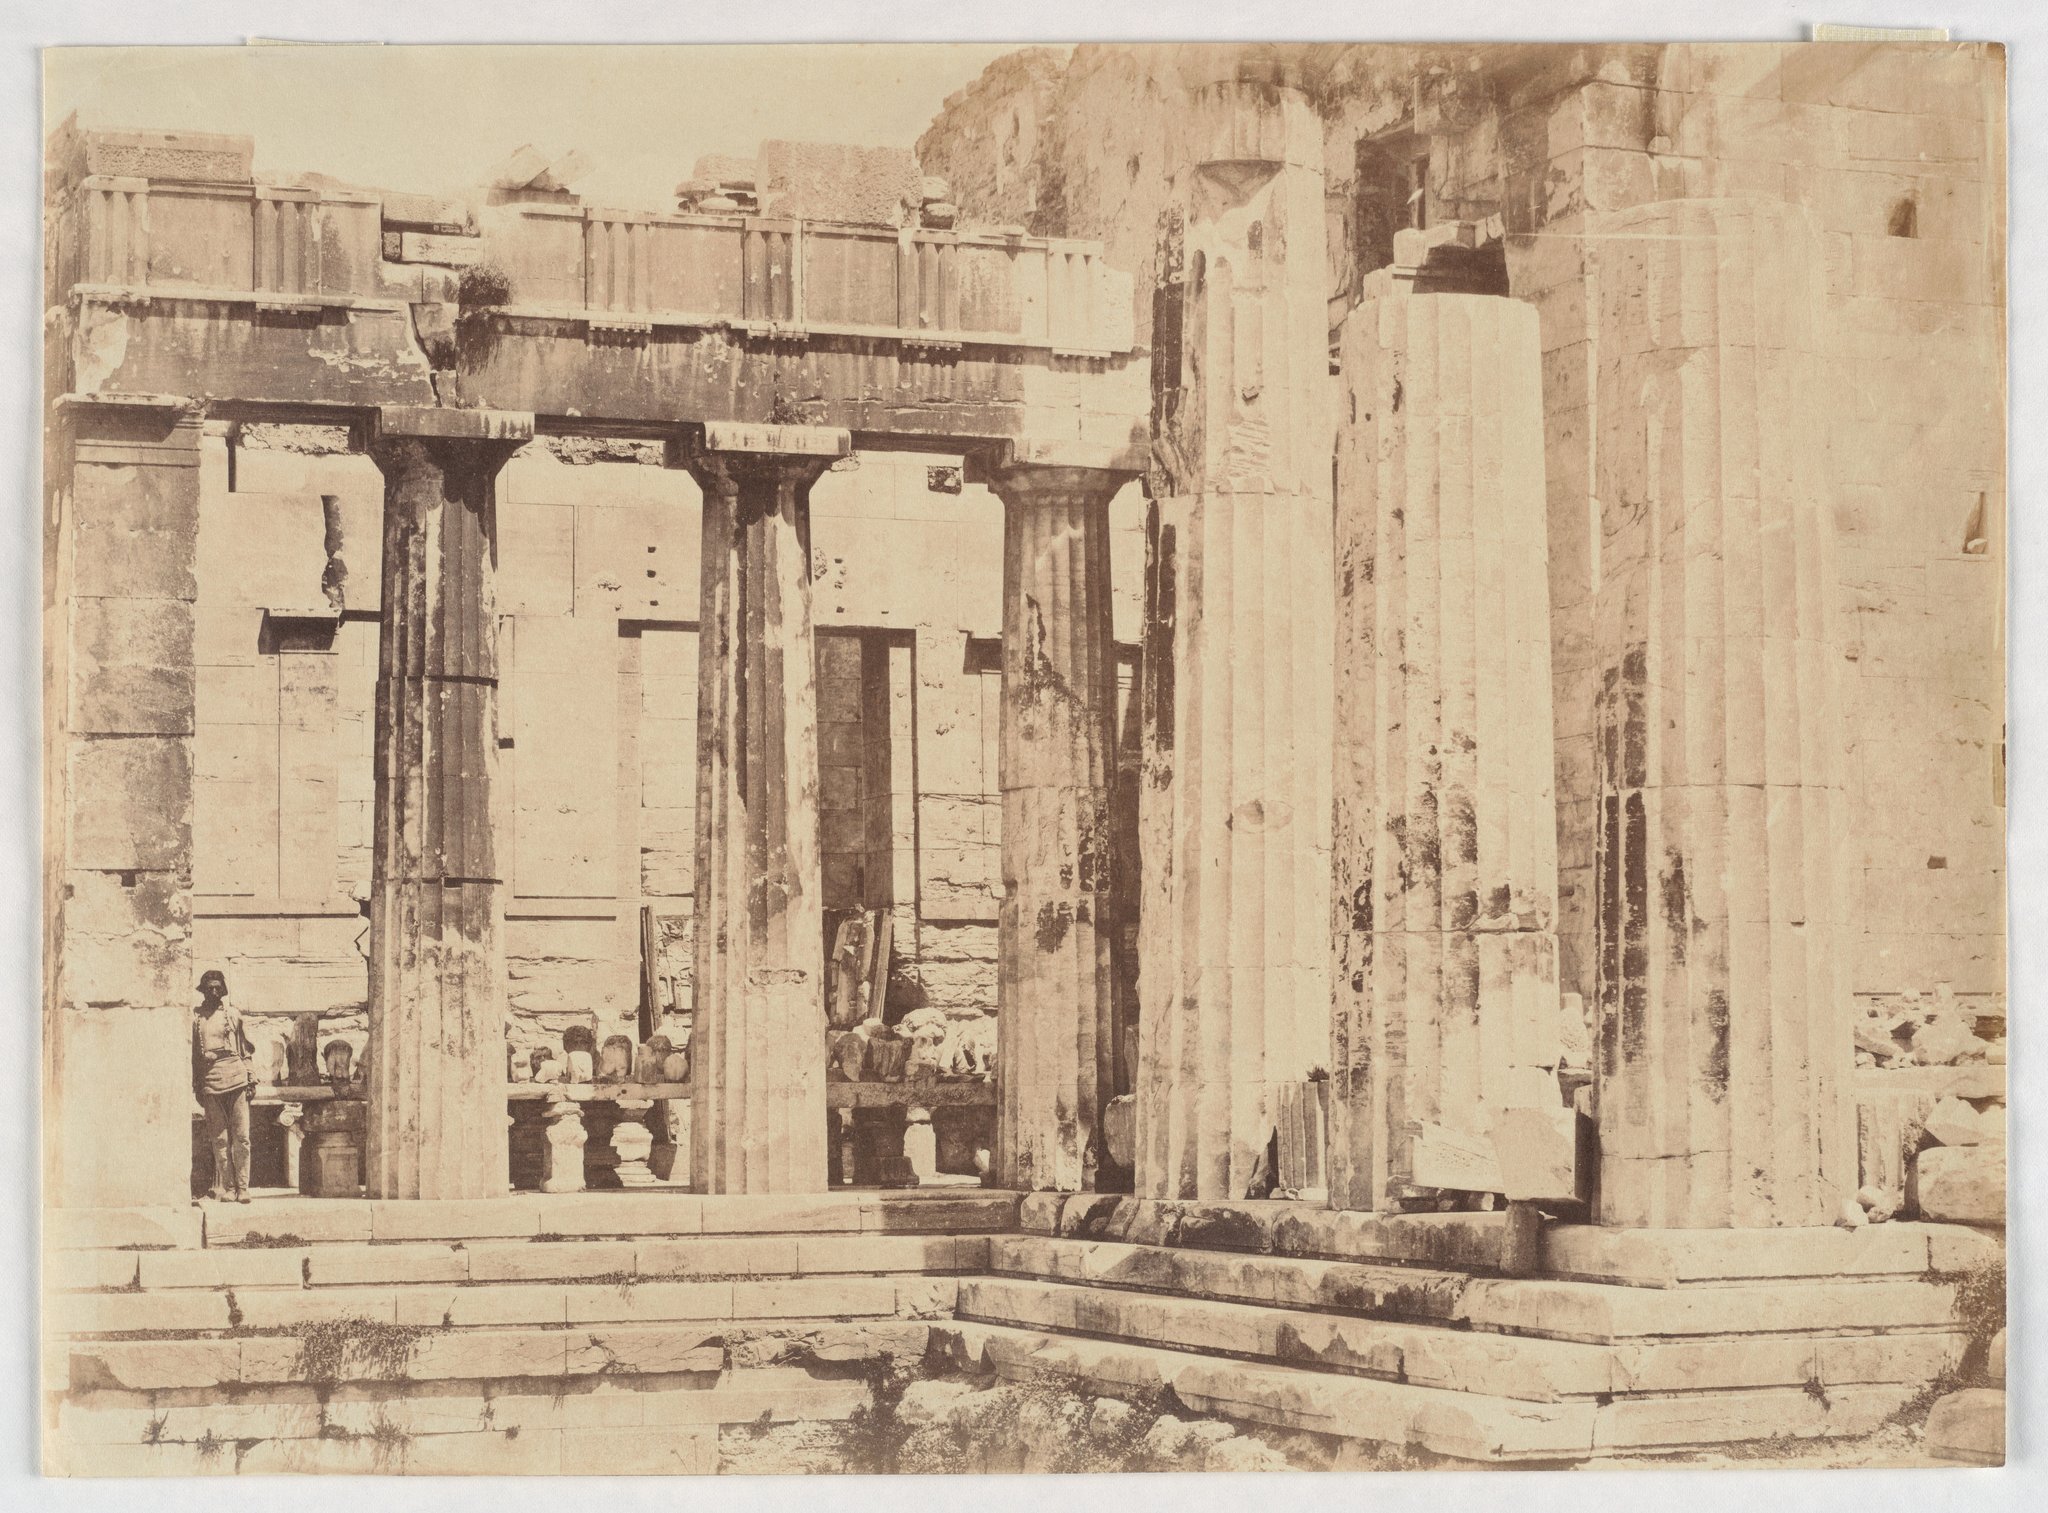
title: [Acropolis, Athens, Greece]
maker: james robertson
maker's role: artist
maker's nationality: british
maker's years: 1813-1881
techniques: salted paper print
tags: columns,ruins